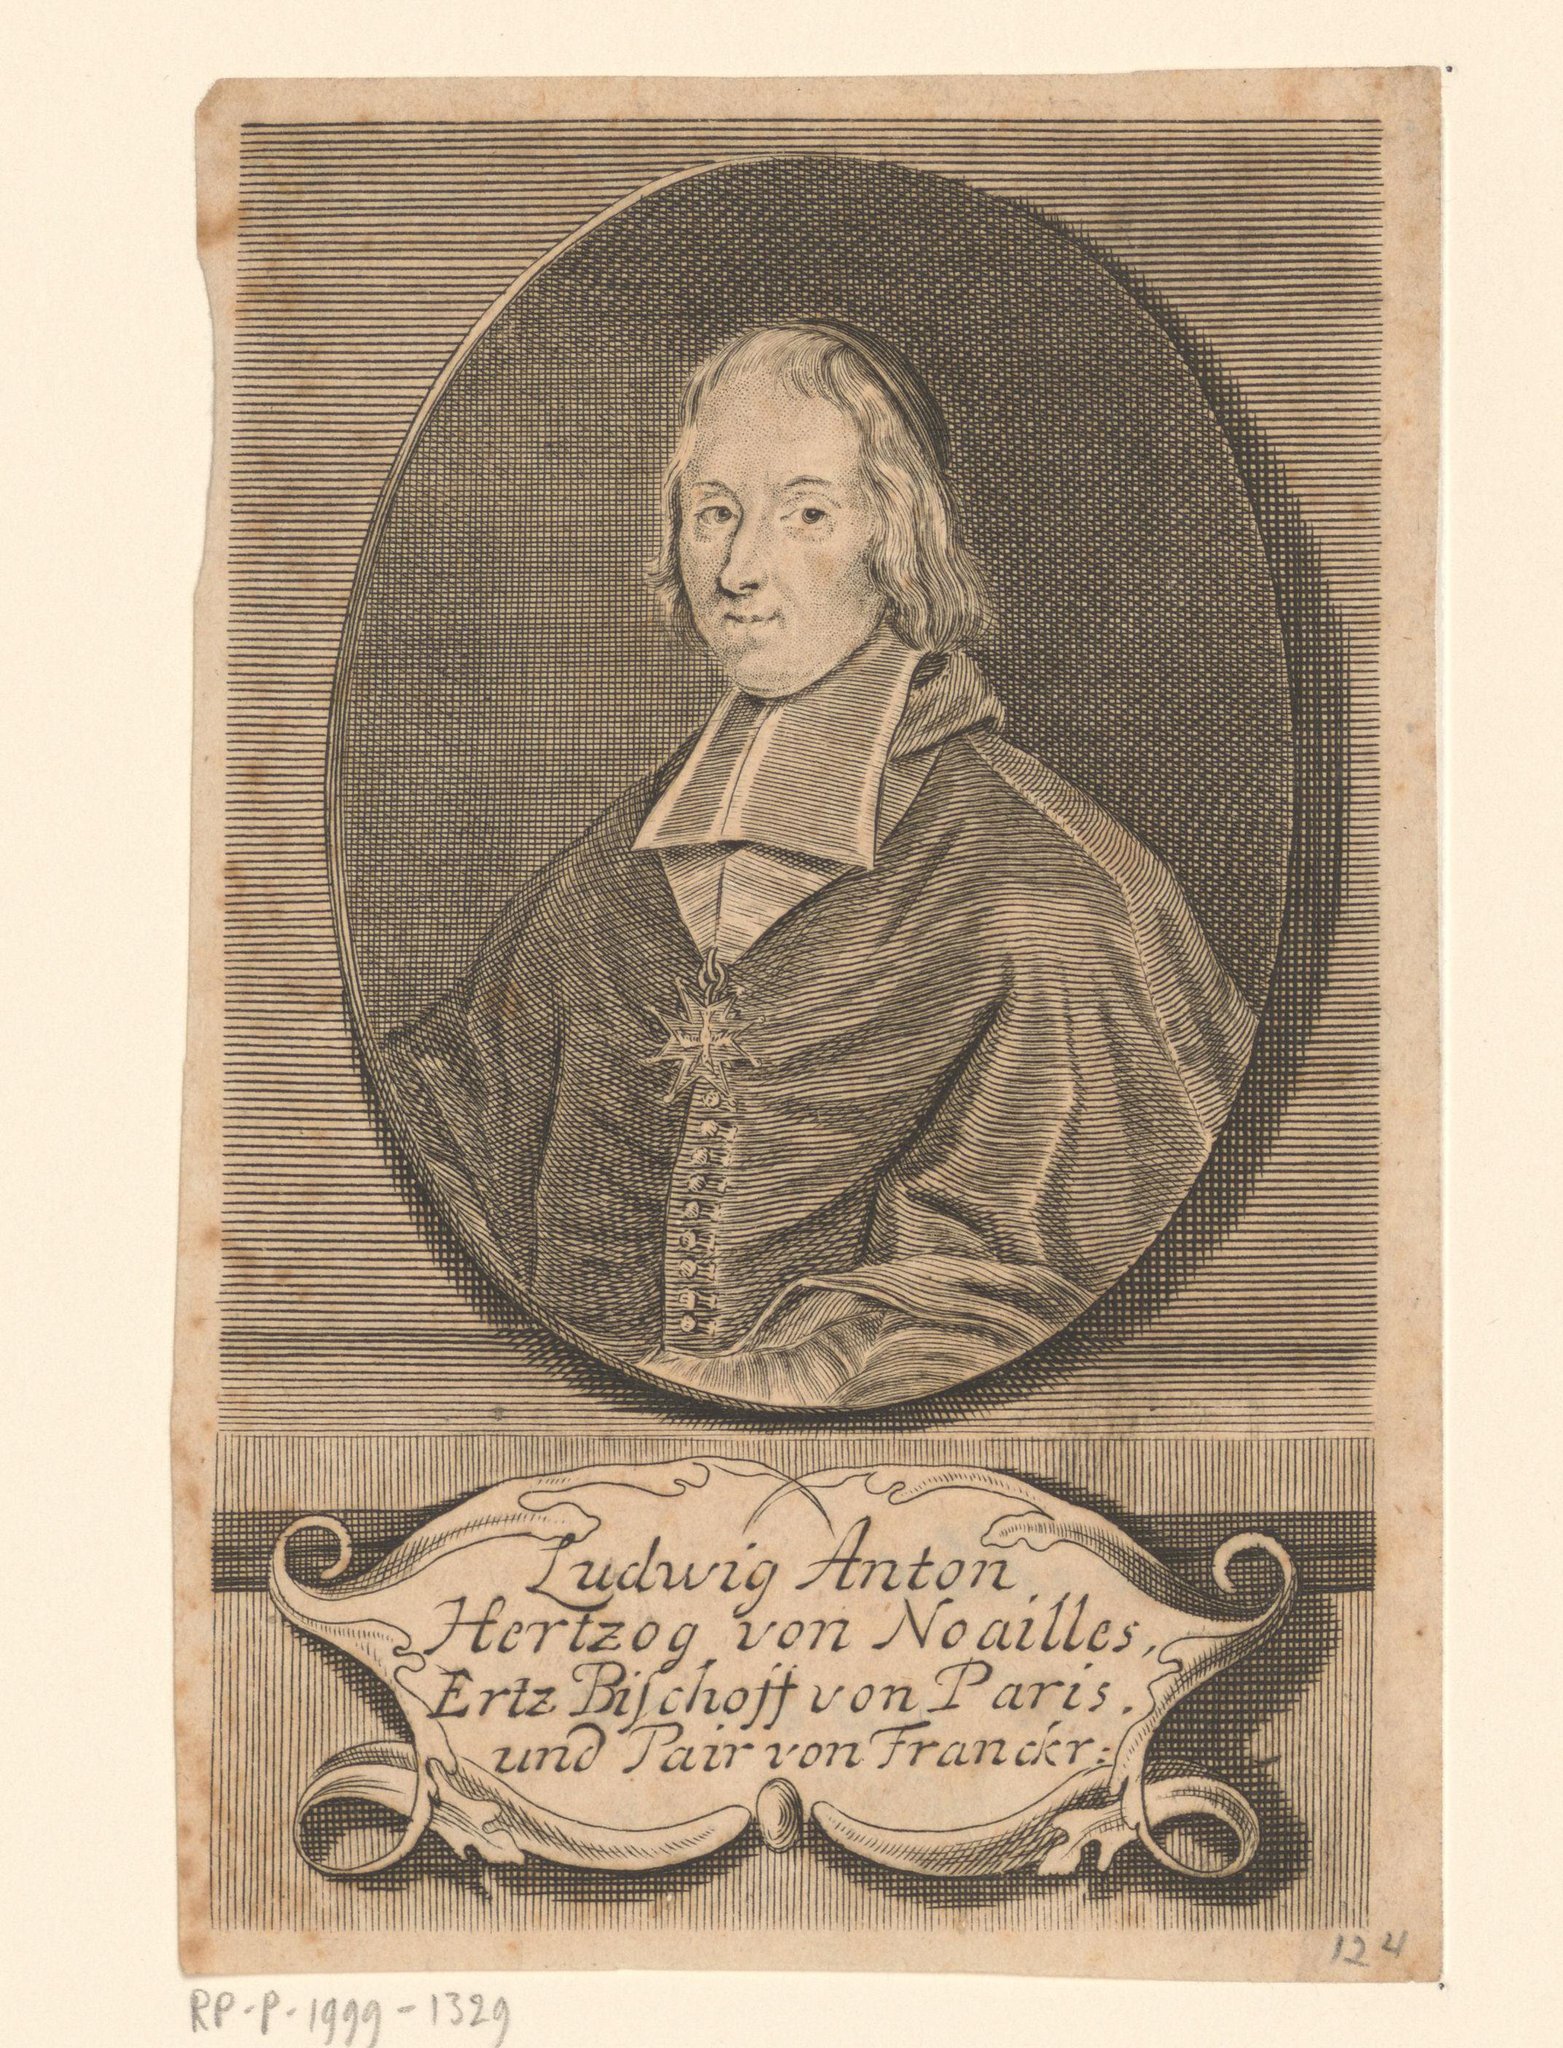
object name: print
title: Portret Ludwig Anton, hertog van Noailles, aartsbisschop van Parijs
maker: Anonymous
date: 1715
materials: paper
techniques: engraving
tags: paris, louis-antoine de noailles, cardinal, historical persons, knighthood order of the holy spirit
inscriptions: collector's mark: Lugt 2228, collector's mark: Lugt 2760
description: Prent mogelijk uit: Die Europäische Fama, welche den gegenwärtigen Zustand der vornehmsten Höfe entdecket. S.l.s.n.,1715, dl. 168.